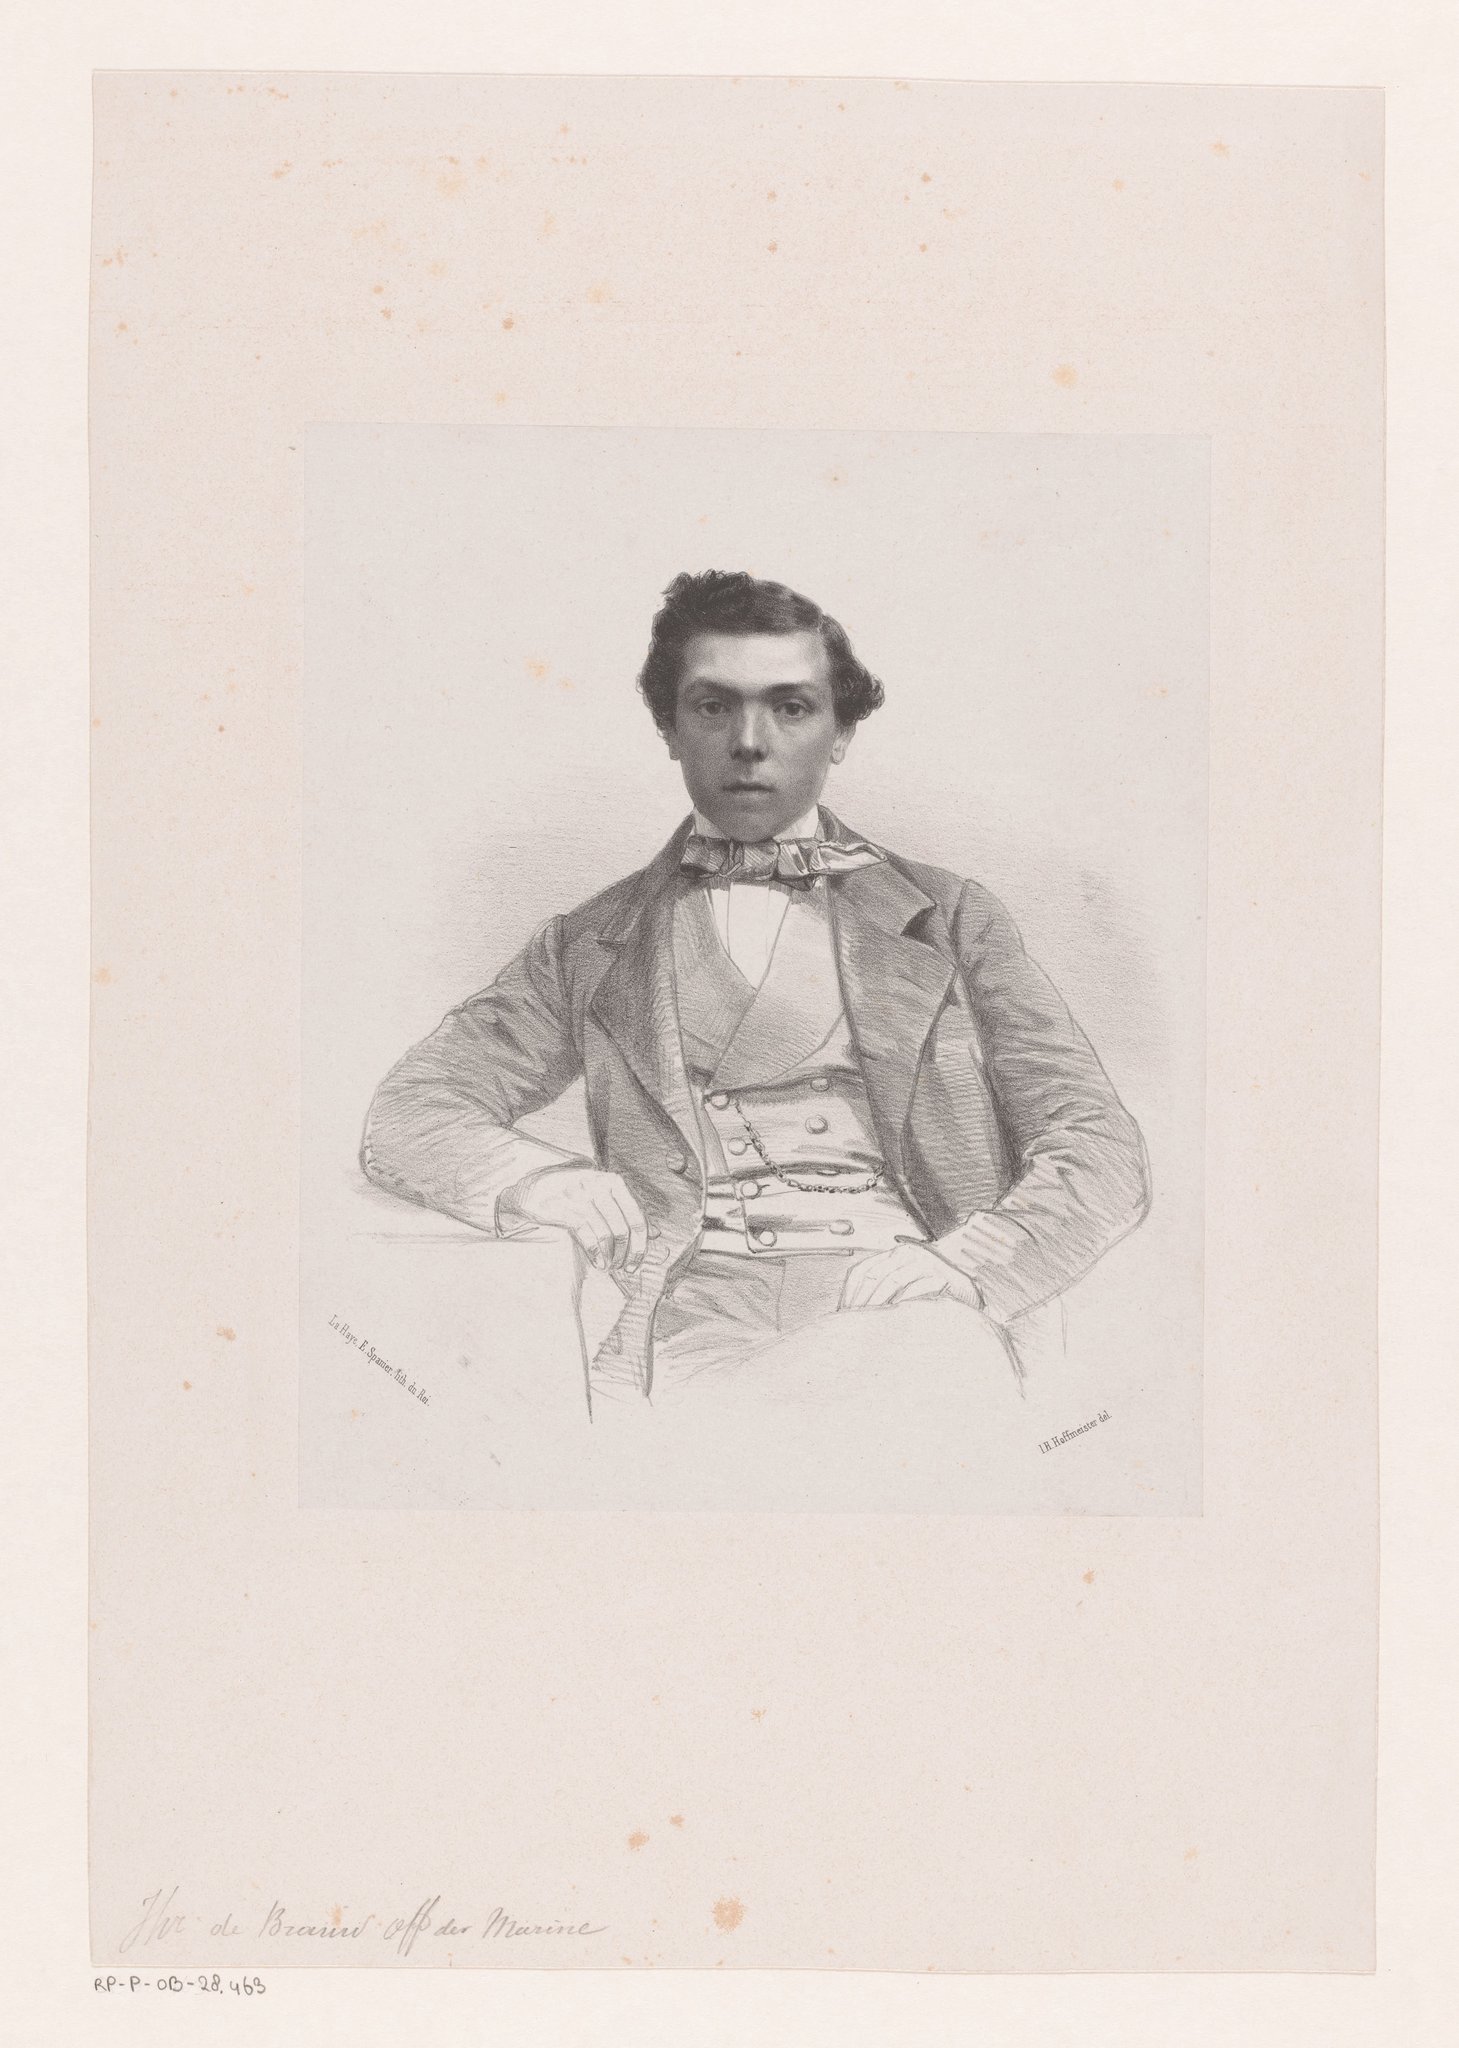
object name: print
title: Portret van Willem Maurits de Brauw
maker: johan hendrik hoffmeister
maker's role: print maker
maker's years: 1823-1904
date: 1851-1883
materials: paper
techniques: lithograph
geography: the hague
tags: historical persons (+ half-length portrait)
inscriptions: collector's mark: Lugt 2228